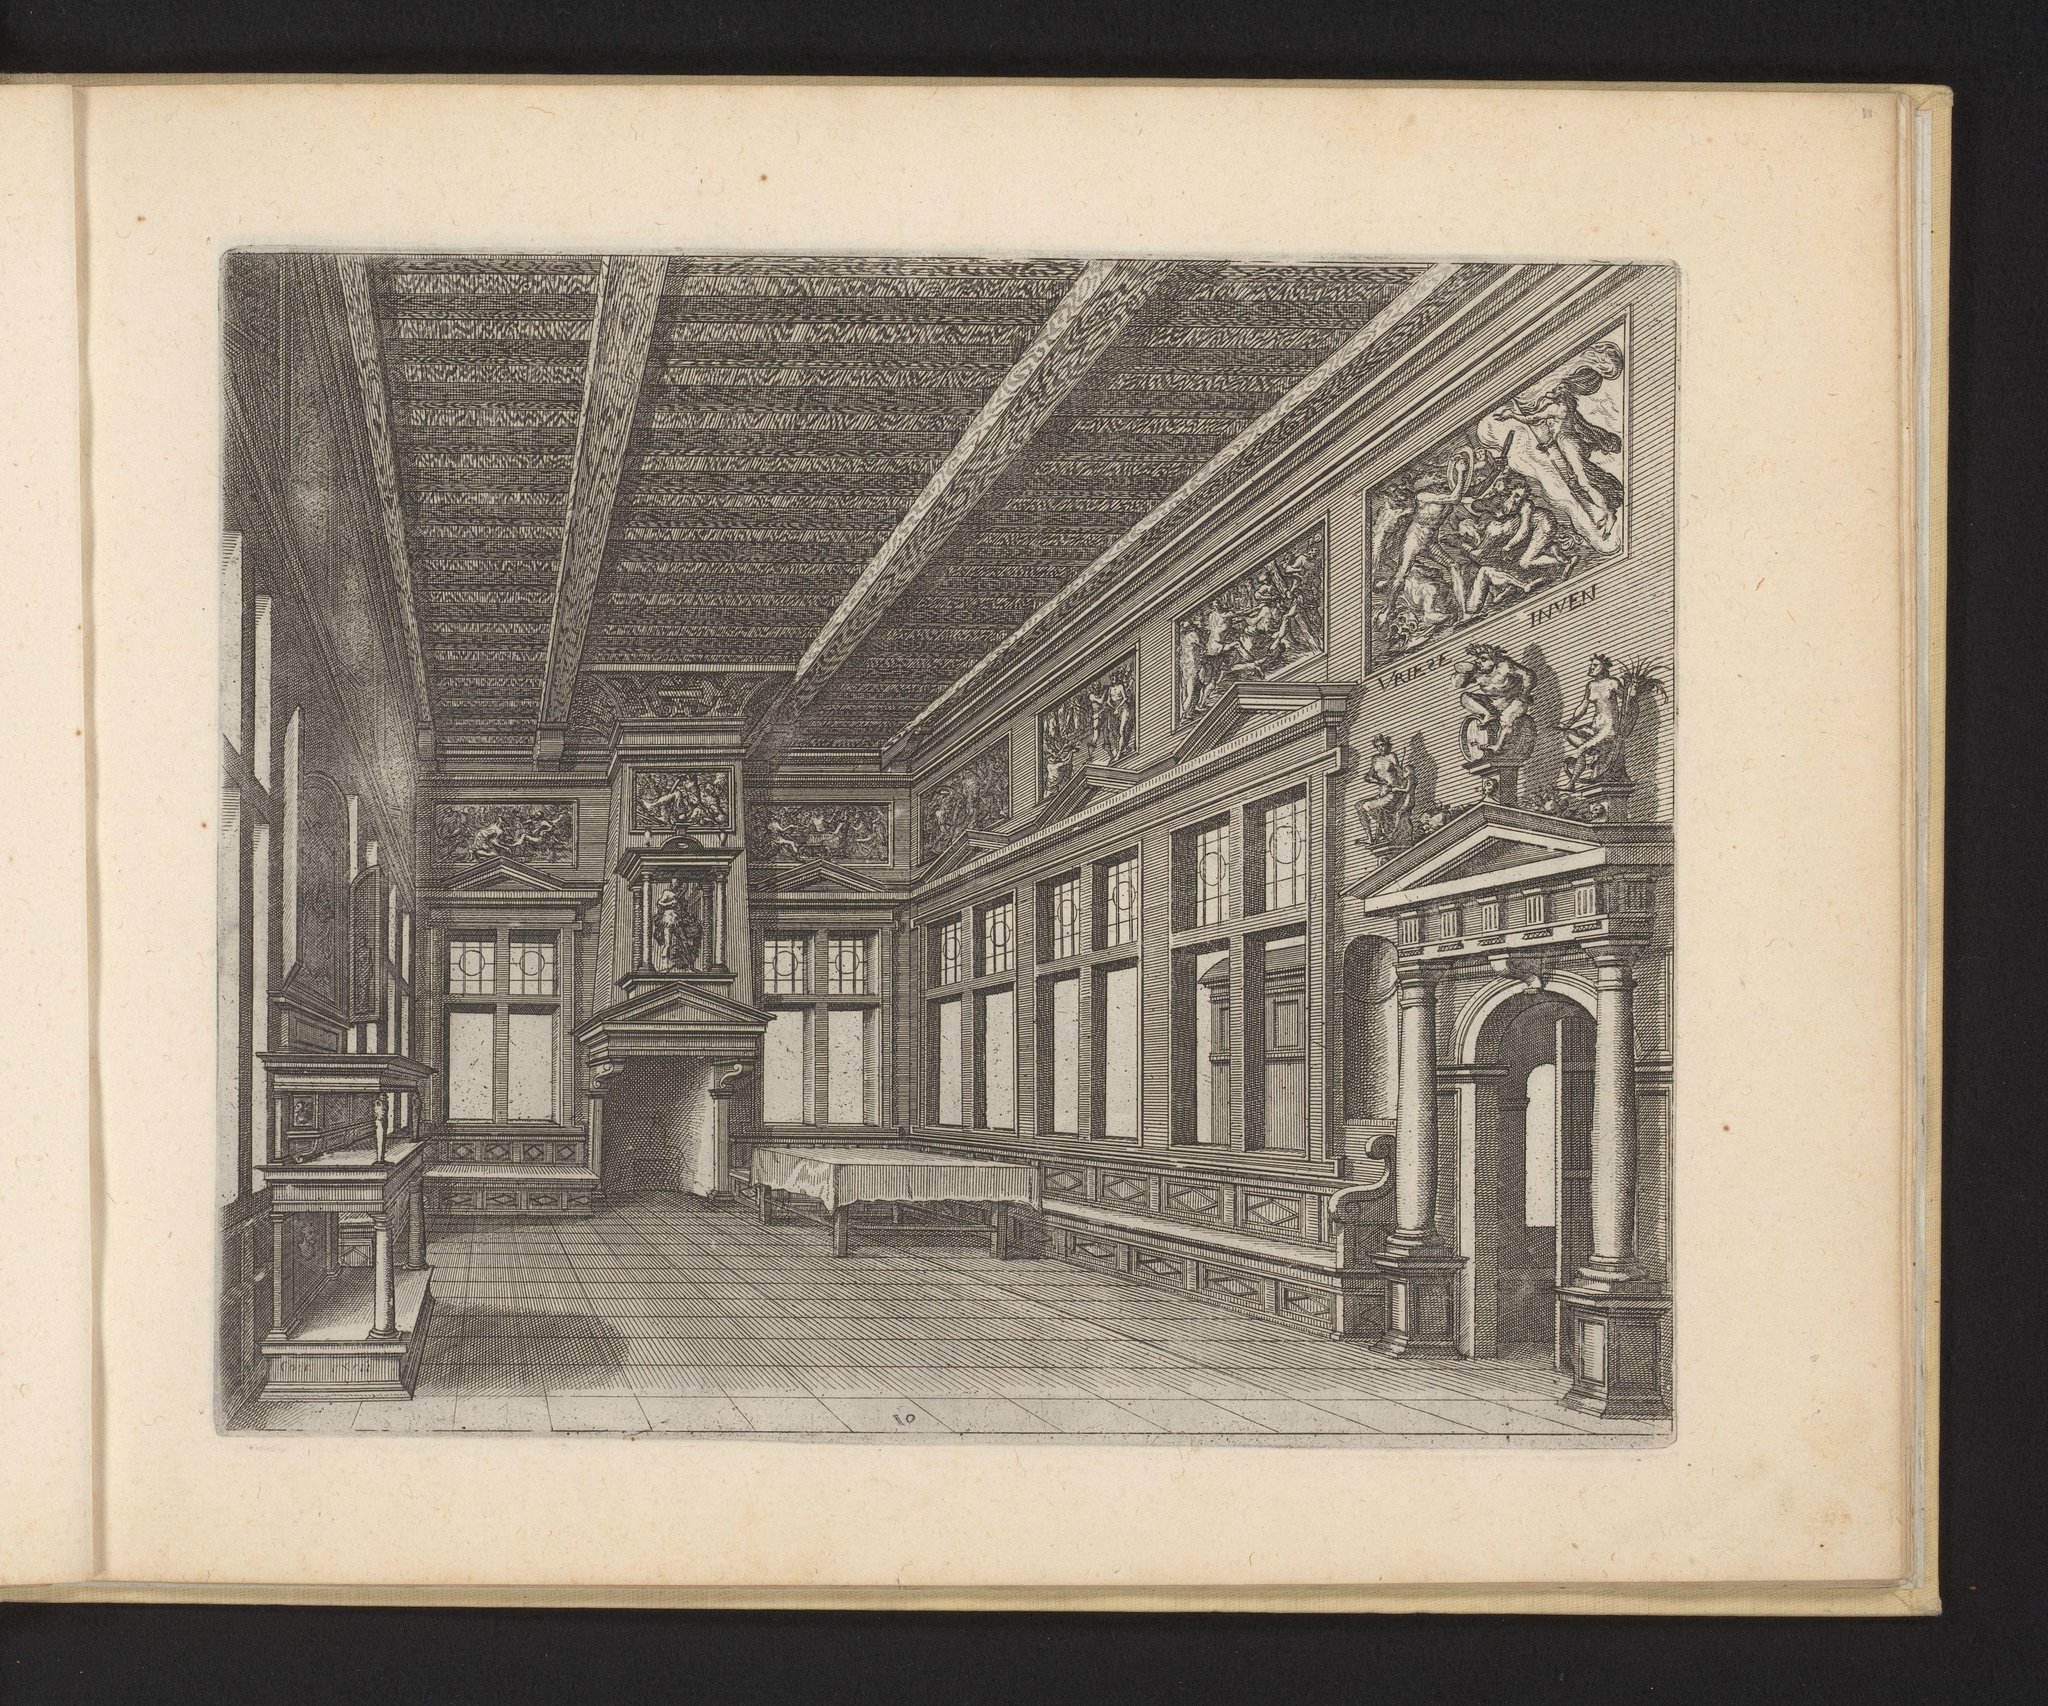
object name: ornament print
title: Variae architecturae formae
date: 1601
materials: paper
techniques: engraving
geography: antwerp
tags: chimney, decorations (interior of the house)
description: Interieur met een balkenplafond, een buffet, een schoorsteenmantel en een tafel. Boven het toegangsportaal drie beelden, waarvan de middelste Bacchus voorstelt. Aan de muren hangen schilderijen. De prent maakt deel uit van een album.